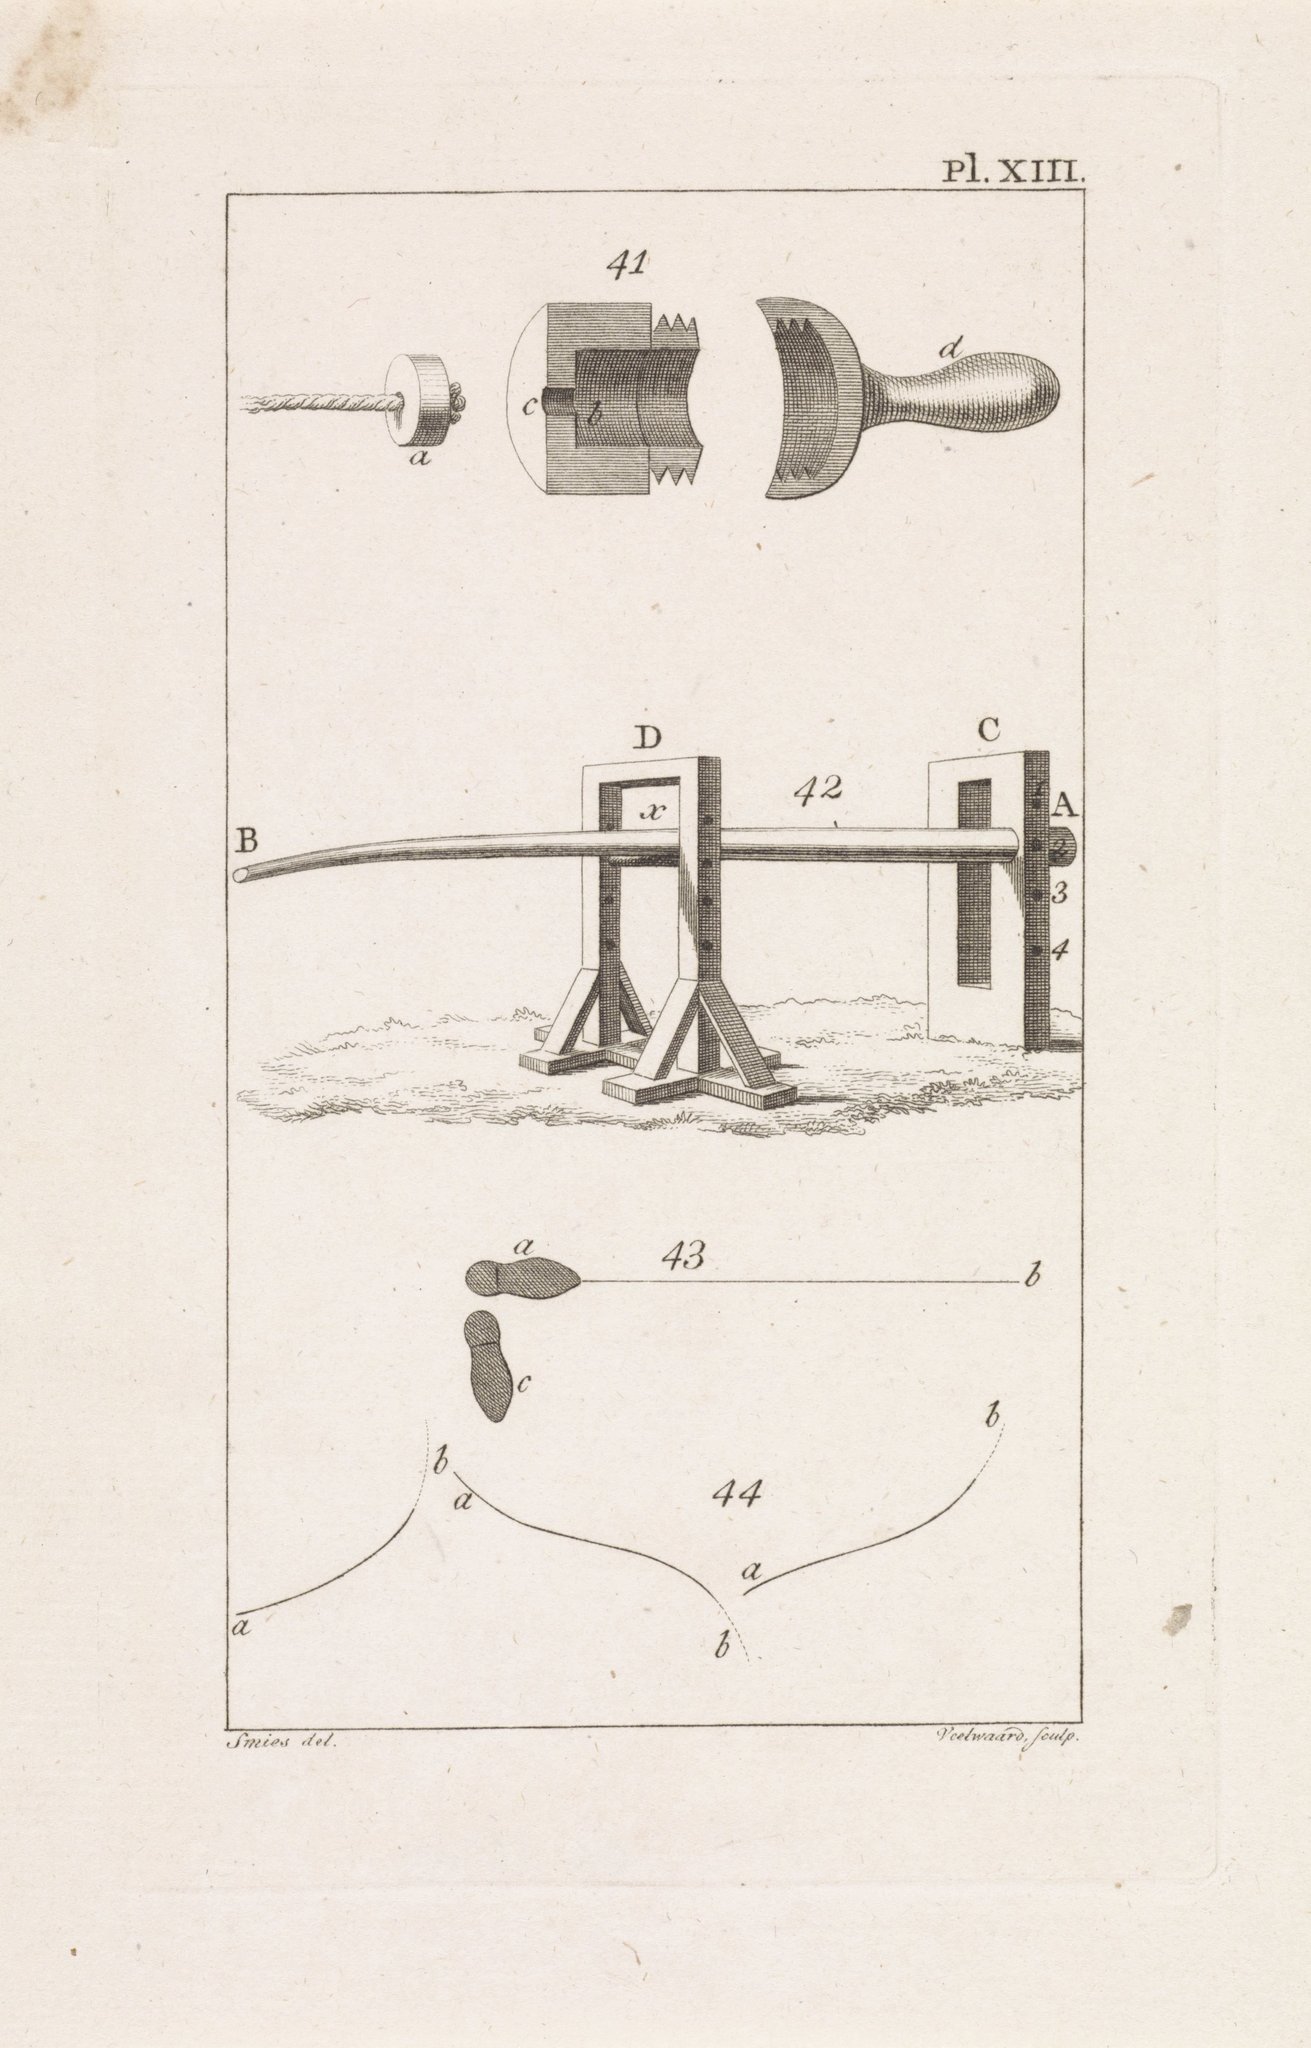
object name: book illustration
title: Lichamelijke oefeningen; apparaten en aanwijzingen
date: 1806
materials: paper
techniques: etching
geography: amsterdam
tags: athletics, gymnastics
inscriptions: collector's mark: Lugt 2228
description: Prent vermoedelijk ook gebruikt als boekillustratie in: Geuns, Jan van. [naar J.C.F. Gutsmuths]. Volledig leerstelsel van kunstmatige ligchaams-oefeningen. Eene bijdrage tot de opvoeding der Jeugd. 2 dln. Leiden en Haarlem: 1806-1812.